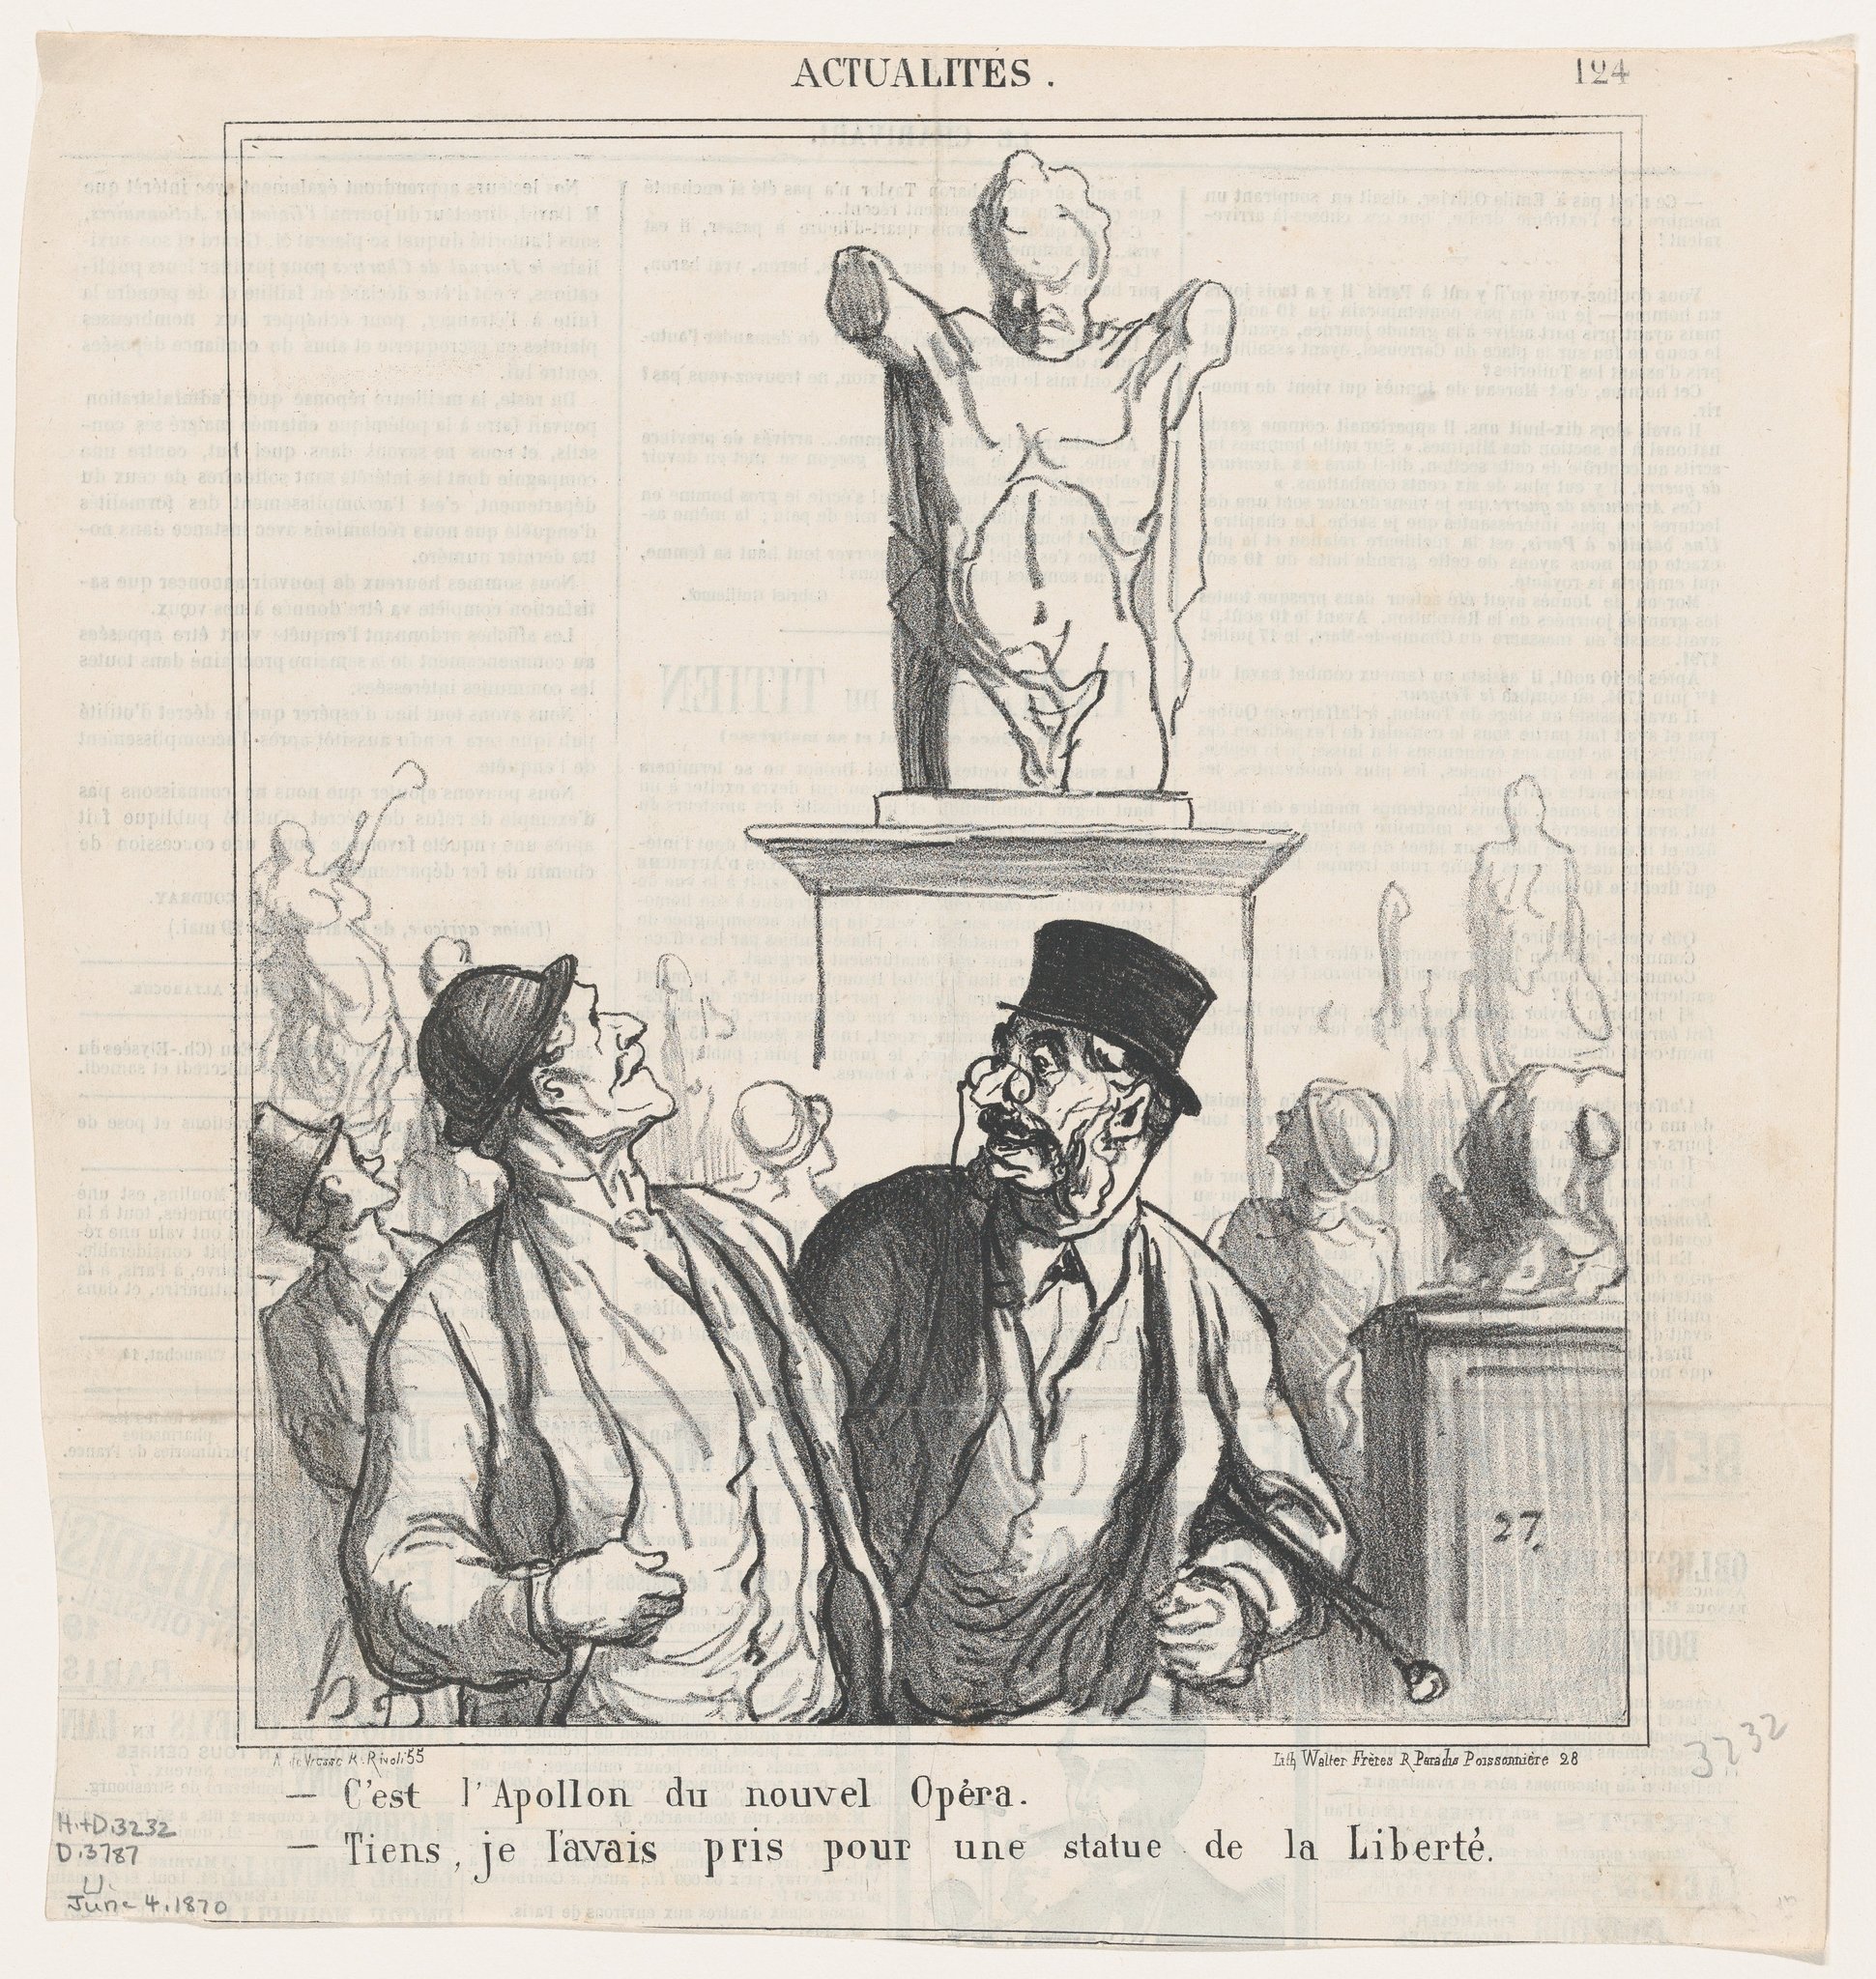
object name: print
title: –It's the Apollo of the new opera. –Well, I had taken it for the statue of liberty, from 'News of the day,' published in Le Charivari, June 4, 1870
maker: honoré daumier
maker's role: artist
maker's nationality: french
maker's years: 1808-1879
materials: paper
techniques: lithograph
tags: satire,sculpture,men